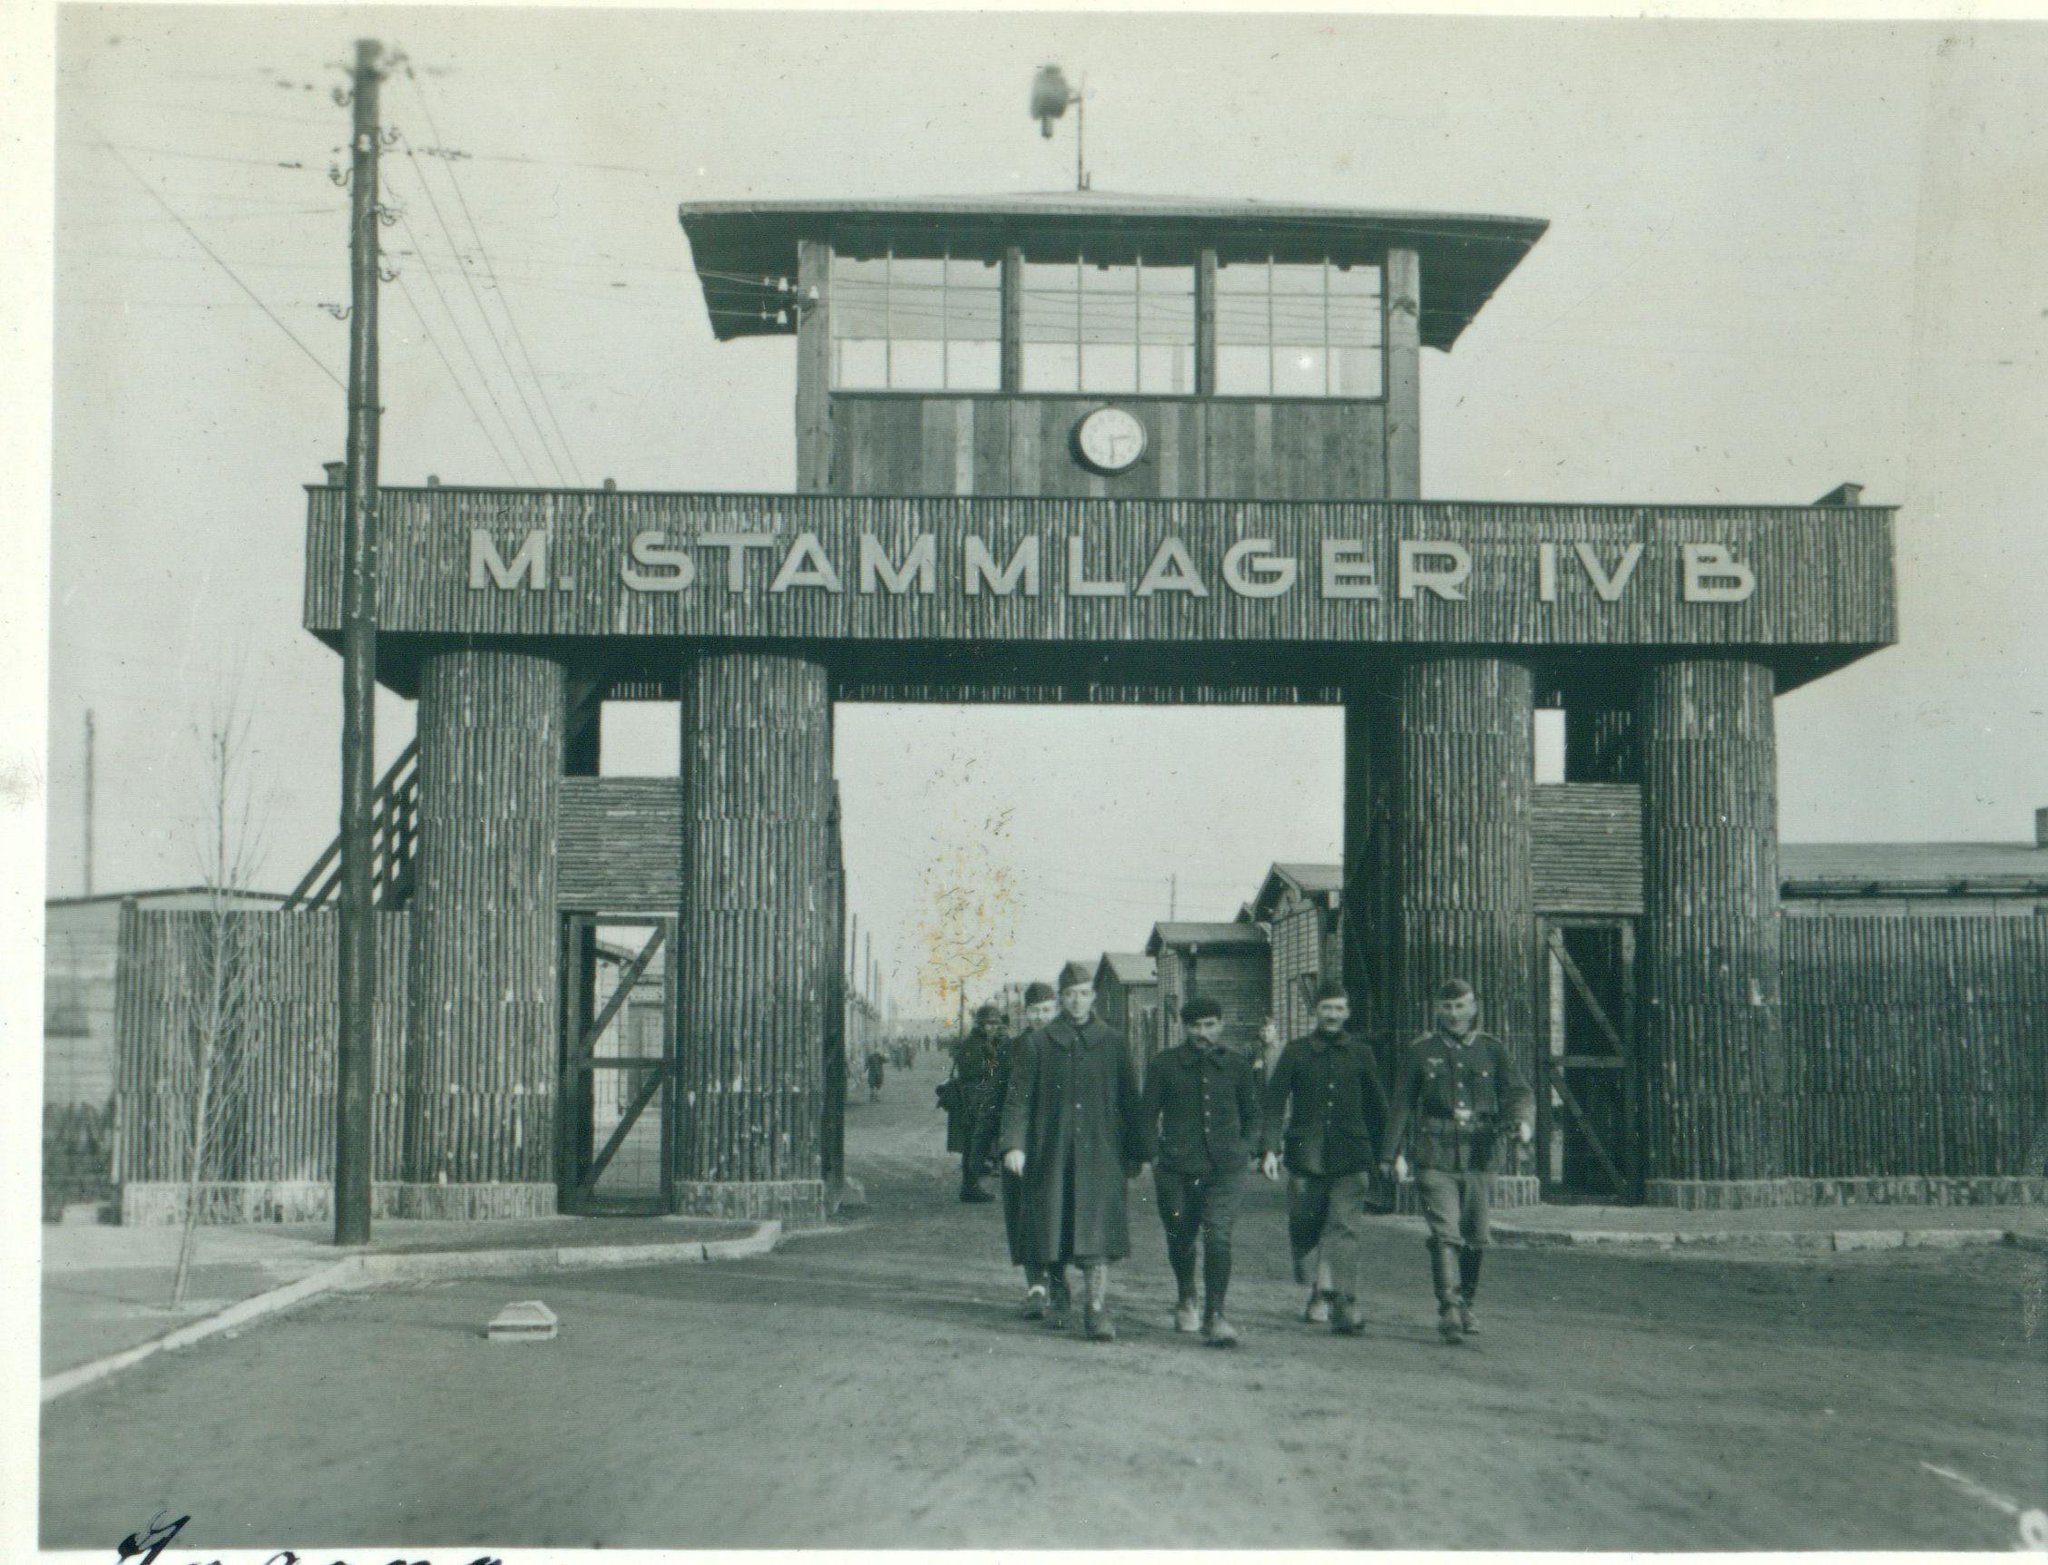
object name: photograph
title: Ingang van het krijgsgevangenenkamp Stalag IV B in Mühlberg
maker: dick w.b. van maarseveen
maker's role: fotograaf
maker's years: 1905-1990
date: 1943-1945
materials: photographic support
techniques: gelatin silver print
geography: muhlberg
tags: the hague, dick w.b. van maarseveen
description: De ingang van Kamp Mühlberg, M. Stammlager IV B. Een groep gevangenen loopt met een Duitse soldaat de poort uit. Onderdeel van een fotoalbum met foto's door Dick van Maarseveen van het krijgsgevangenenkamp Stalag IV B in Mühlberg in de periode 1943-1945.